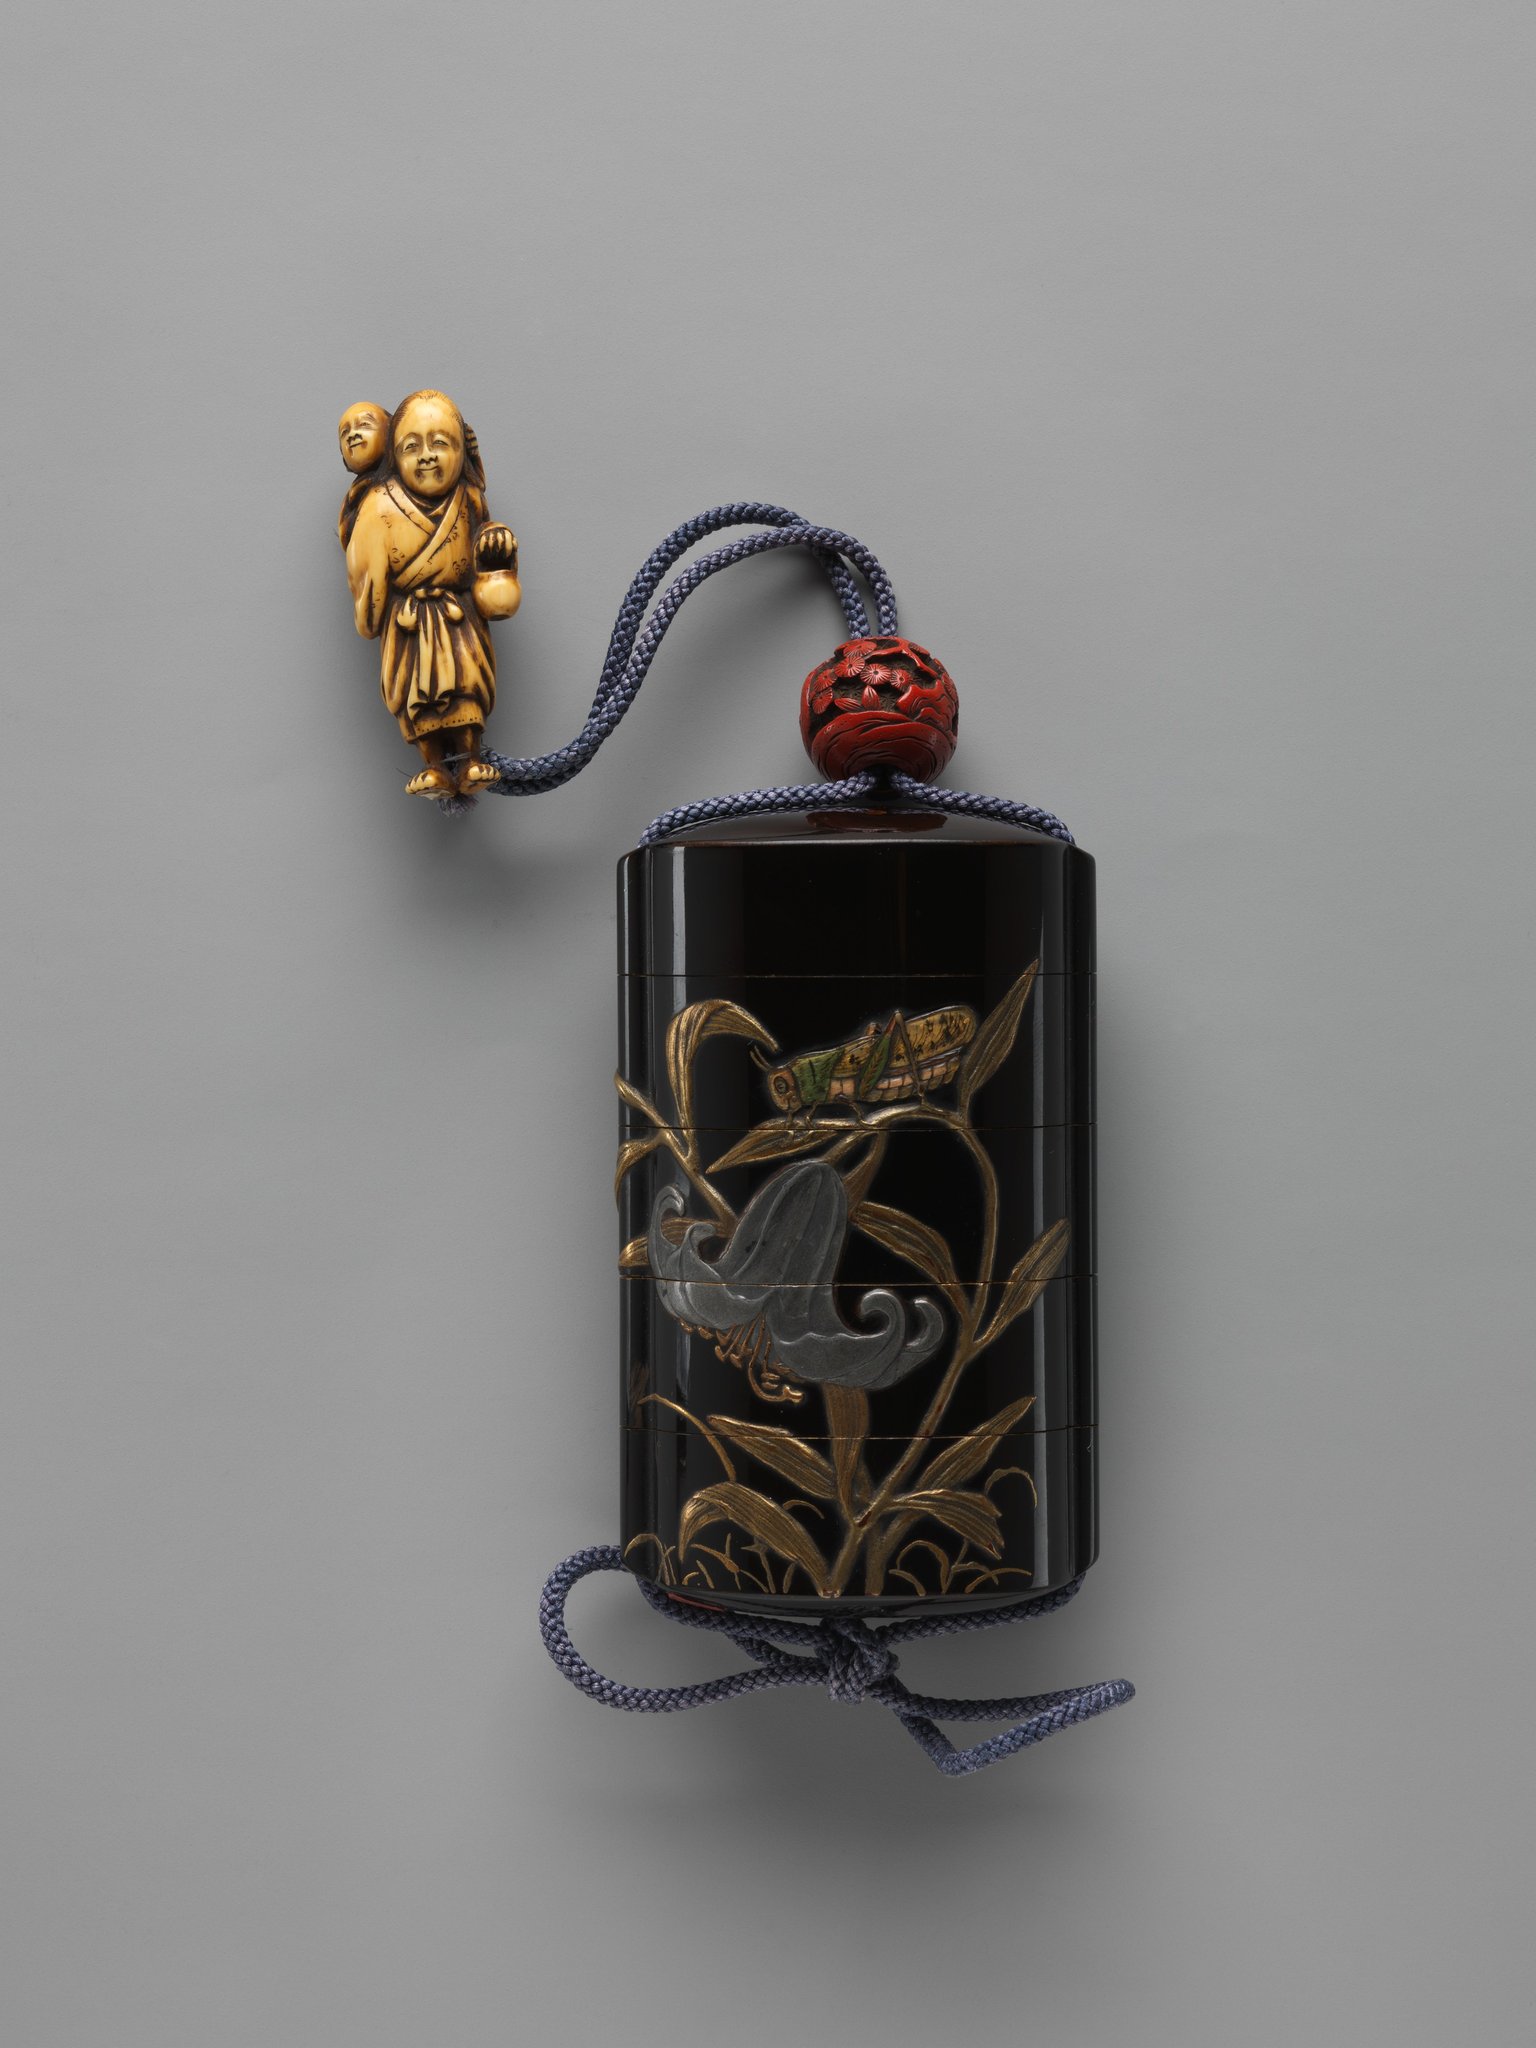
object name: inrō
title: Case (Inrō) with Design of Grasshopper on Stalk of Flowering Lily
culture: japanese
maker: nomura chōkei (dates unknown)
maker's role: artist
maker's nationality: japanese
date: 1701-1900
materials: ceramic, gold, ivory, lacquer, mother of pearl, pewter, wood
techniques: carving, incising, inlay, maki, stain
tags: human figures,insects,lilies